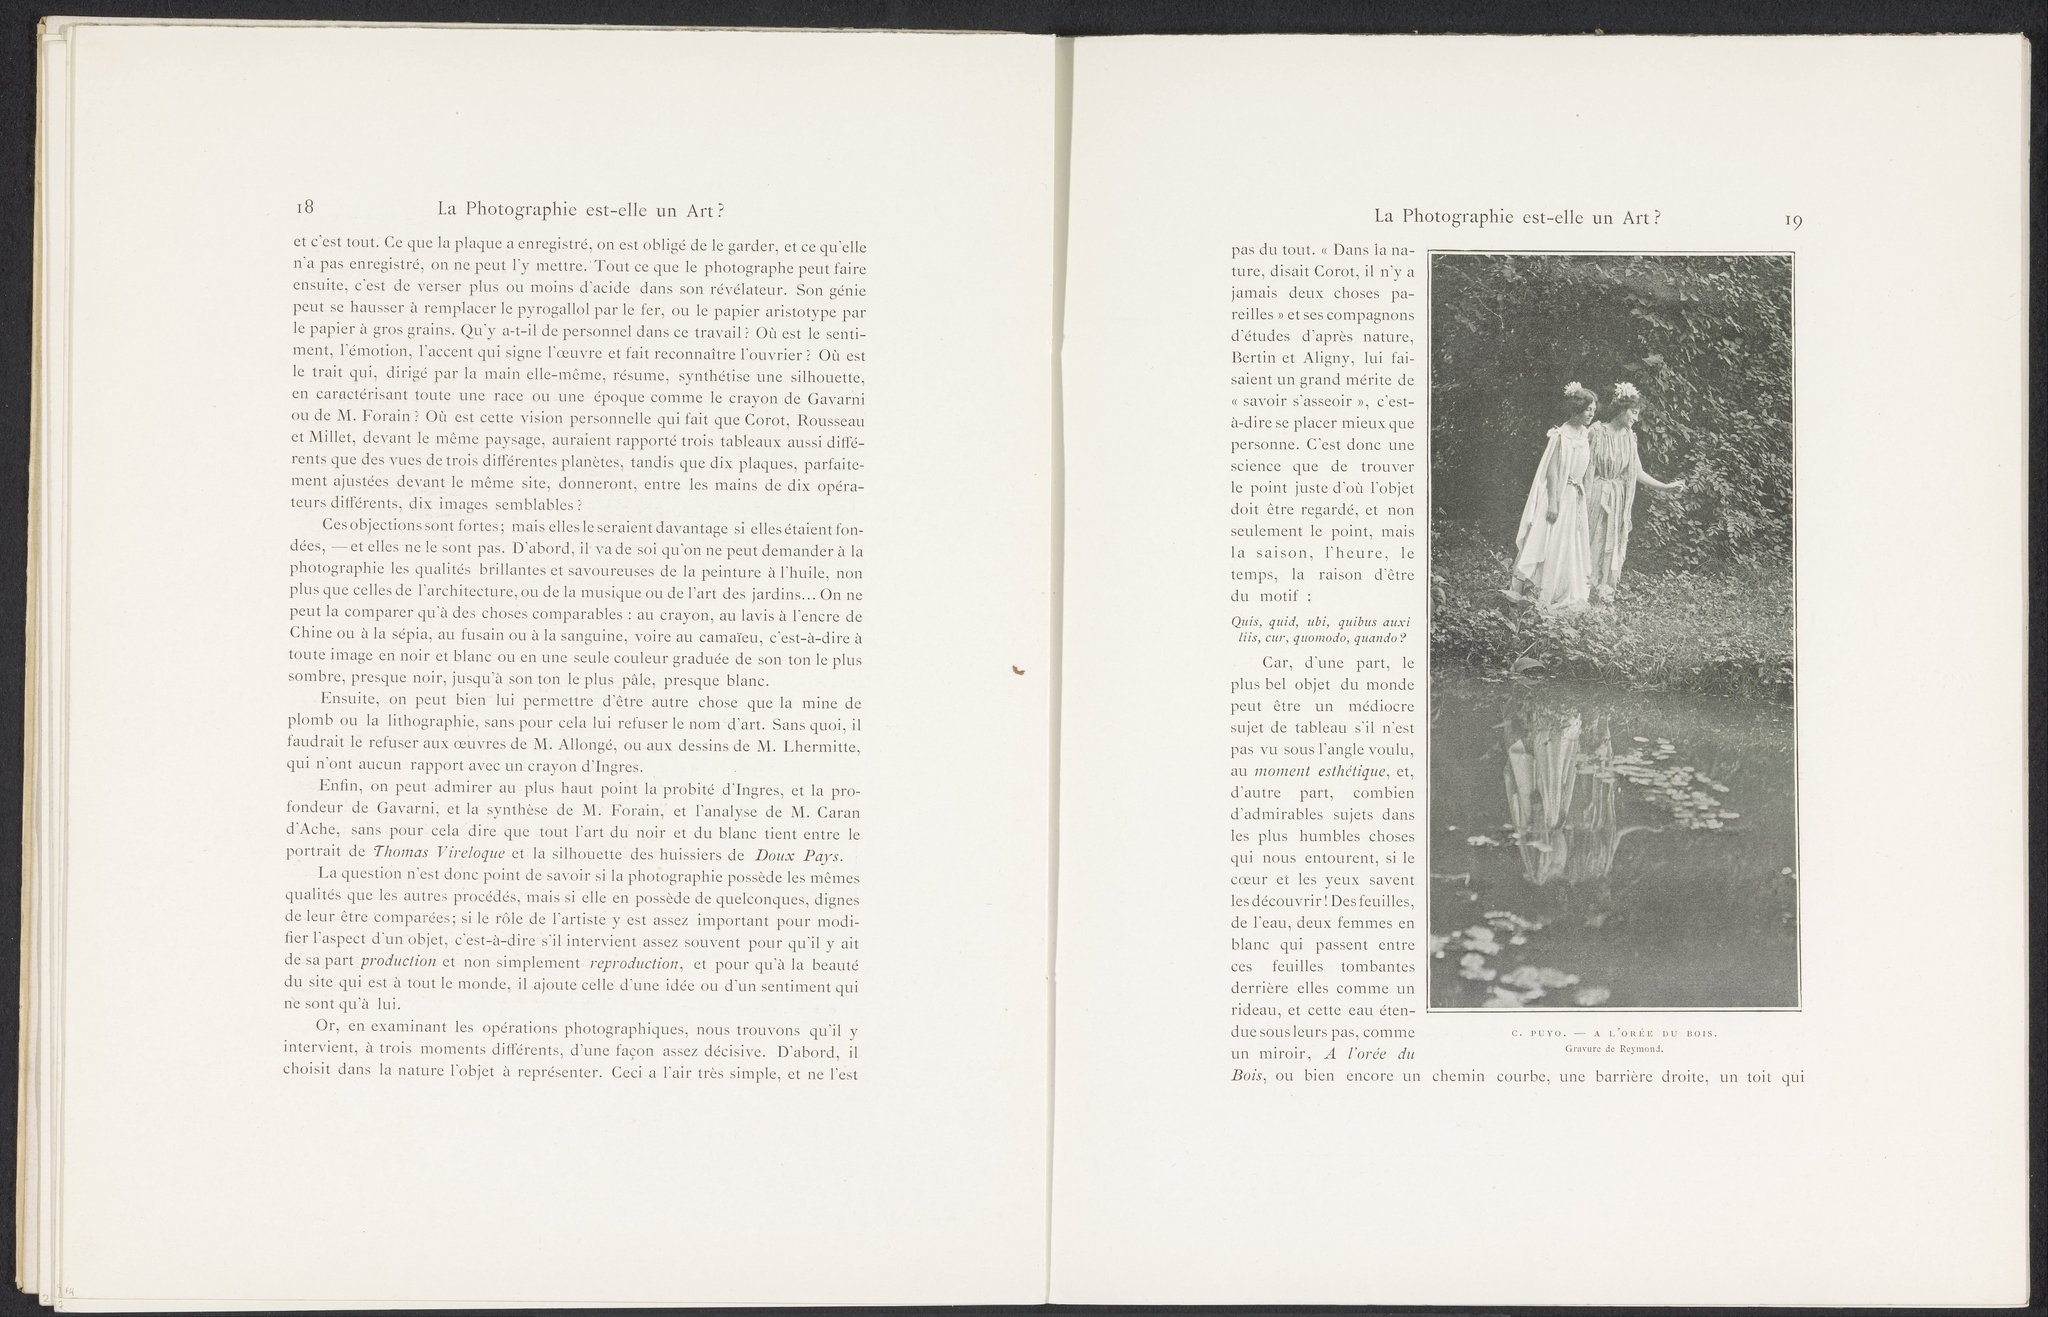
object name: page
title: Twee vrouwen aan een waterkant met hun weerspiegeling in het water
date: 1889-1899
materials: paper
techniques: autotype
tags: forest, wood - hh - ideal landscapes, pond, pool